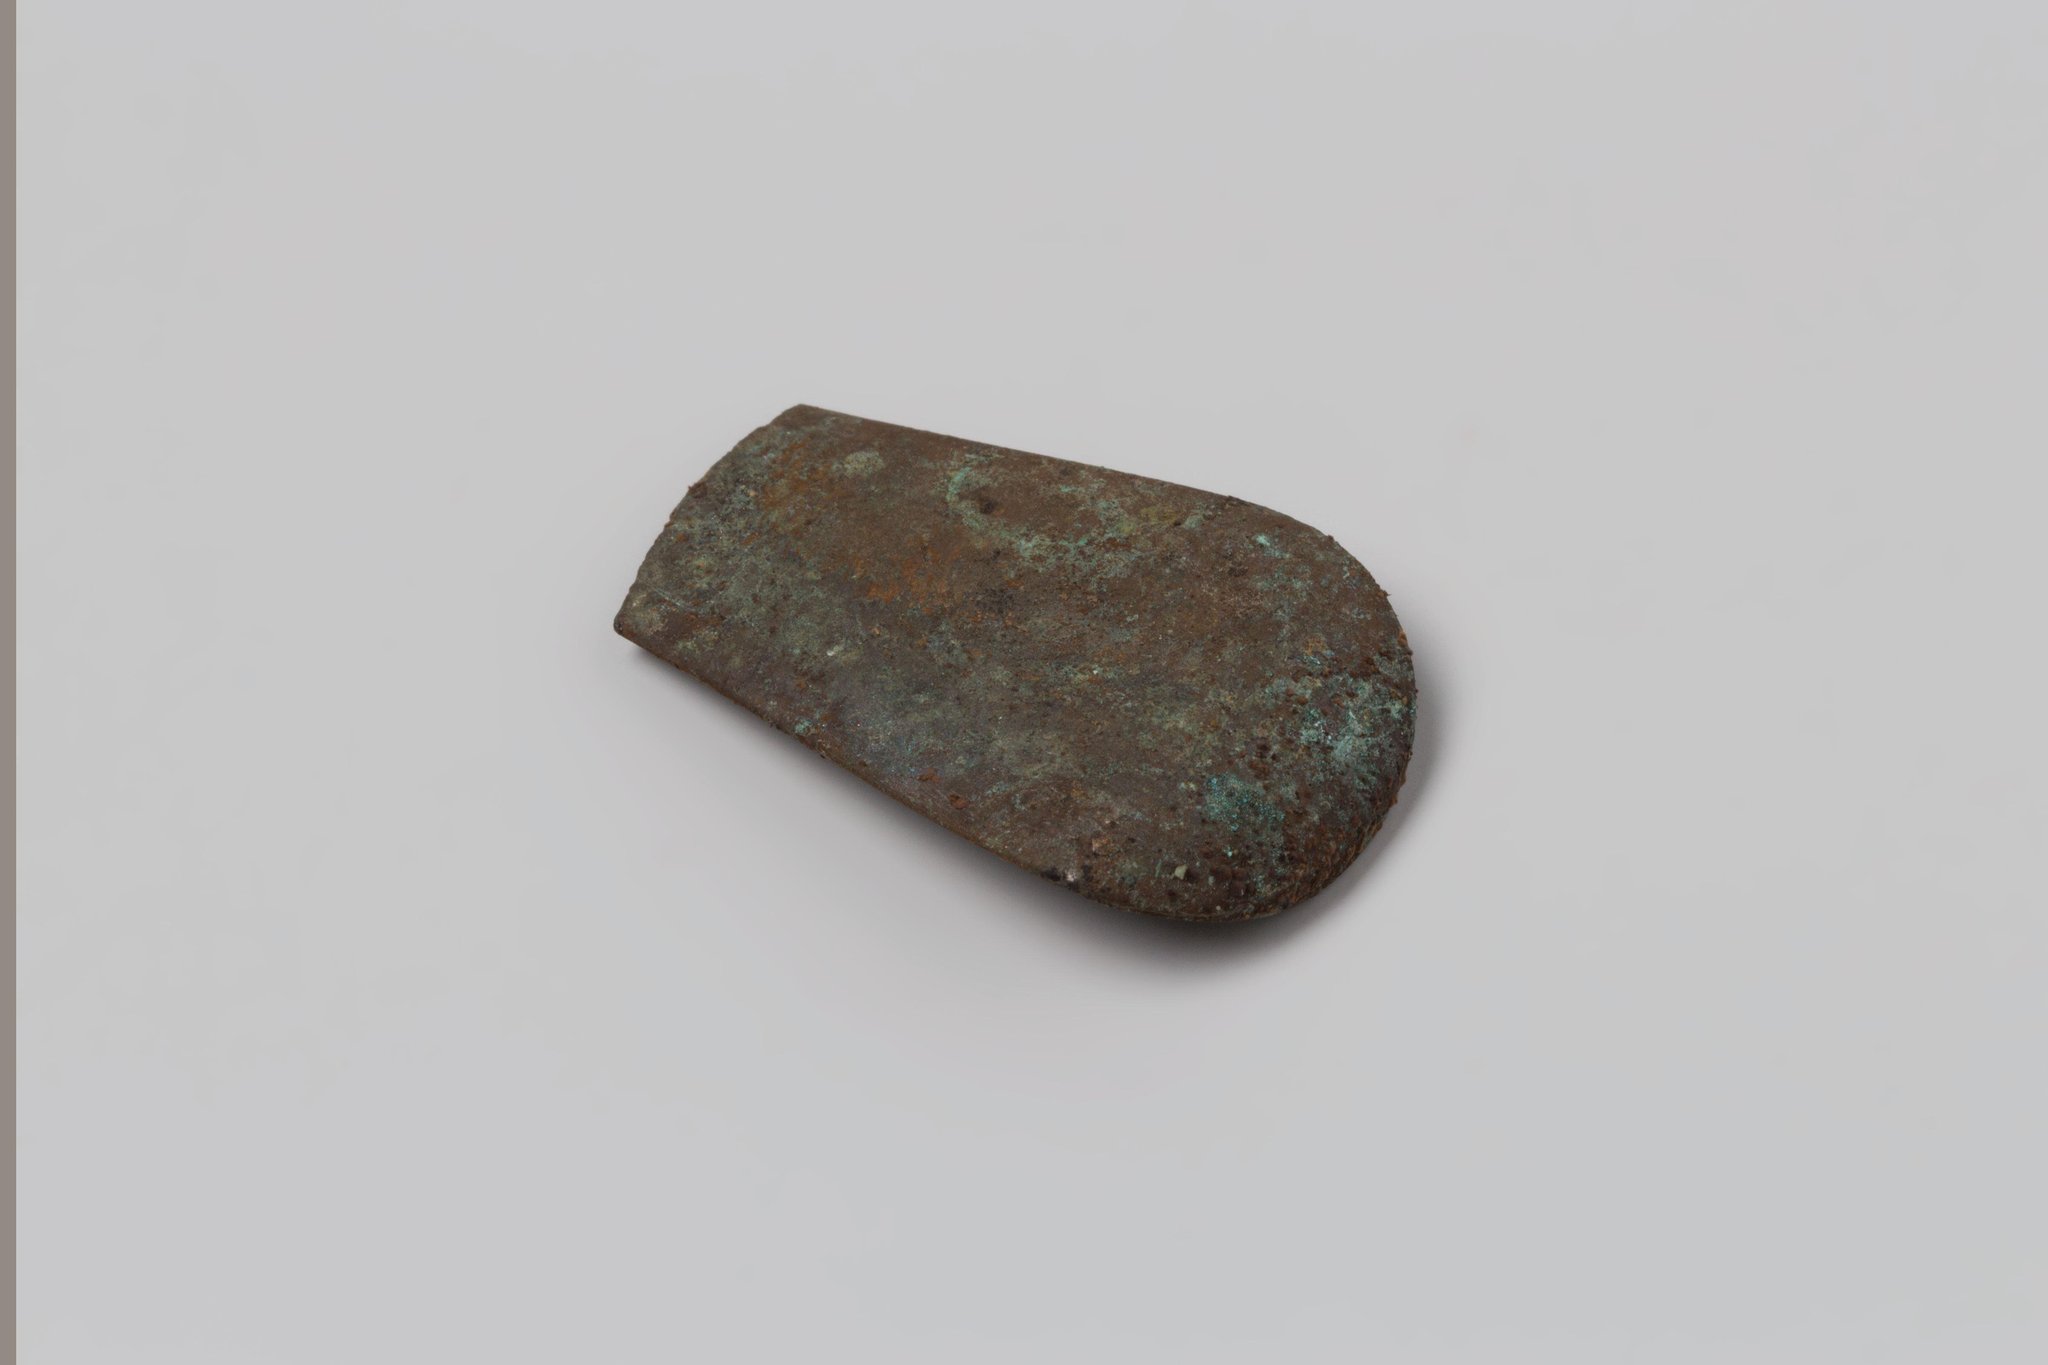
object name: spoon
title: Fragment steel van vork of lepel uit het wrak van de Oost-Indiëvaarder Hollandia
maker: Anonymous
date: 1700-1743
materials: copper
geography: netherlands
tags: verenigde oostindische compagnie, hollandia (schip), annet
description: Cutlery, fragment: stem of fork or spoon; fragm, id. NG 1980-27H1373a.